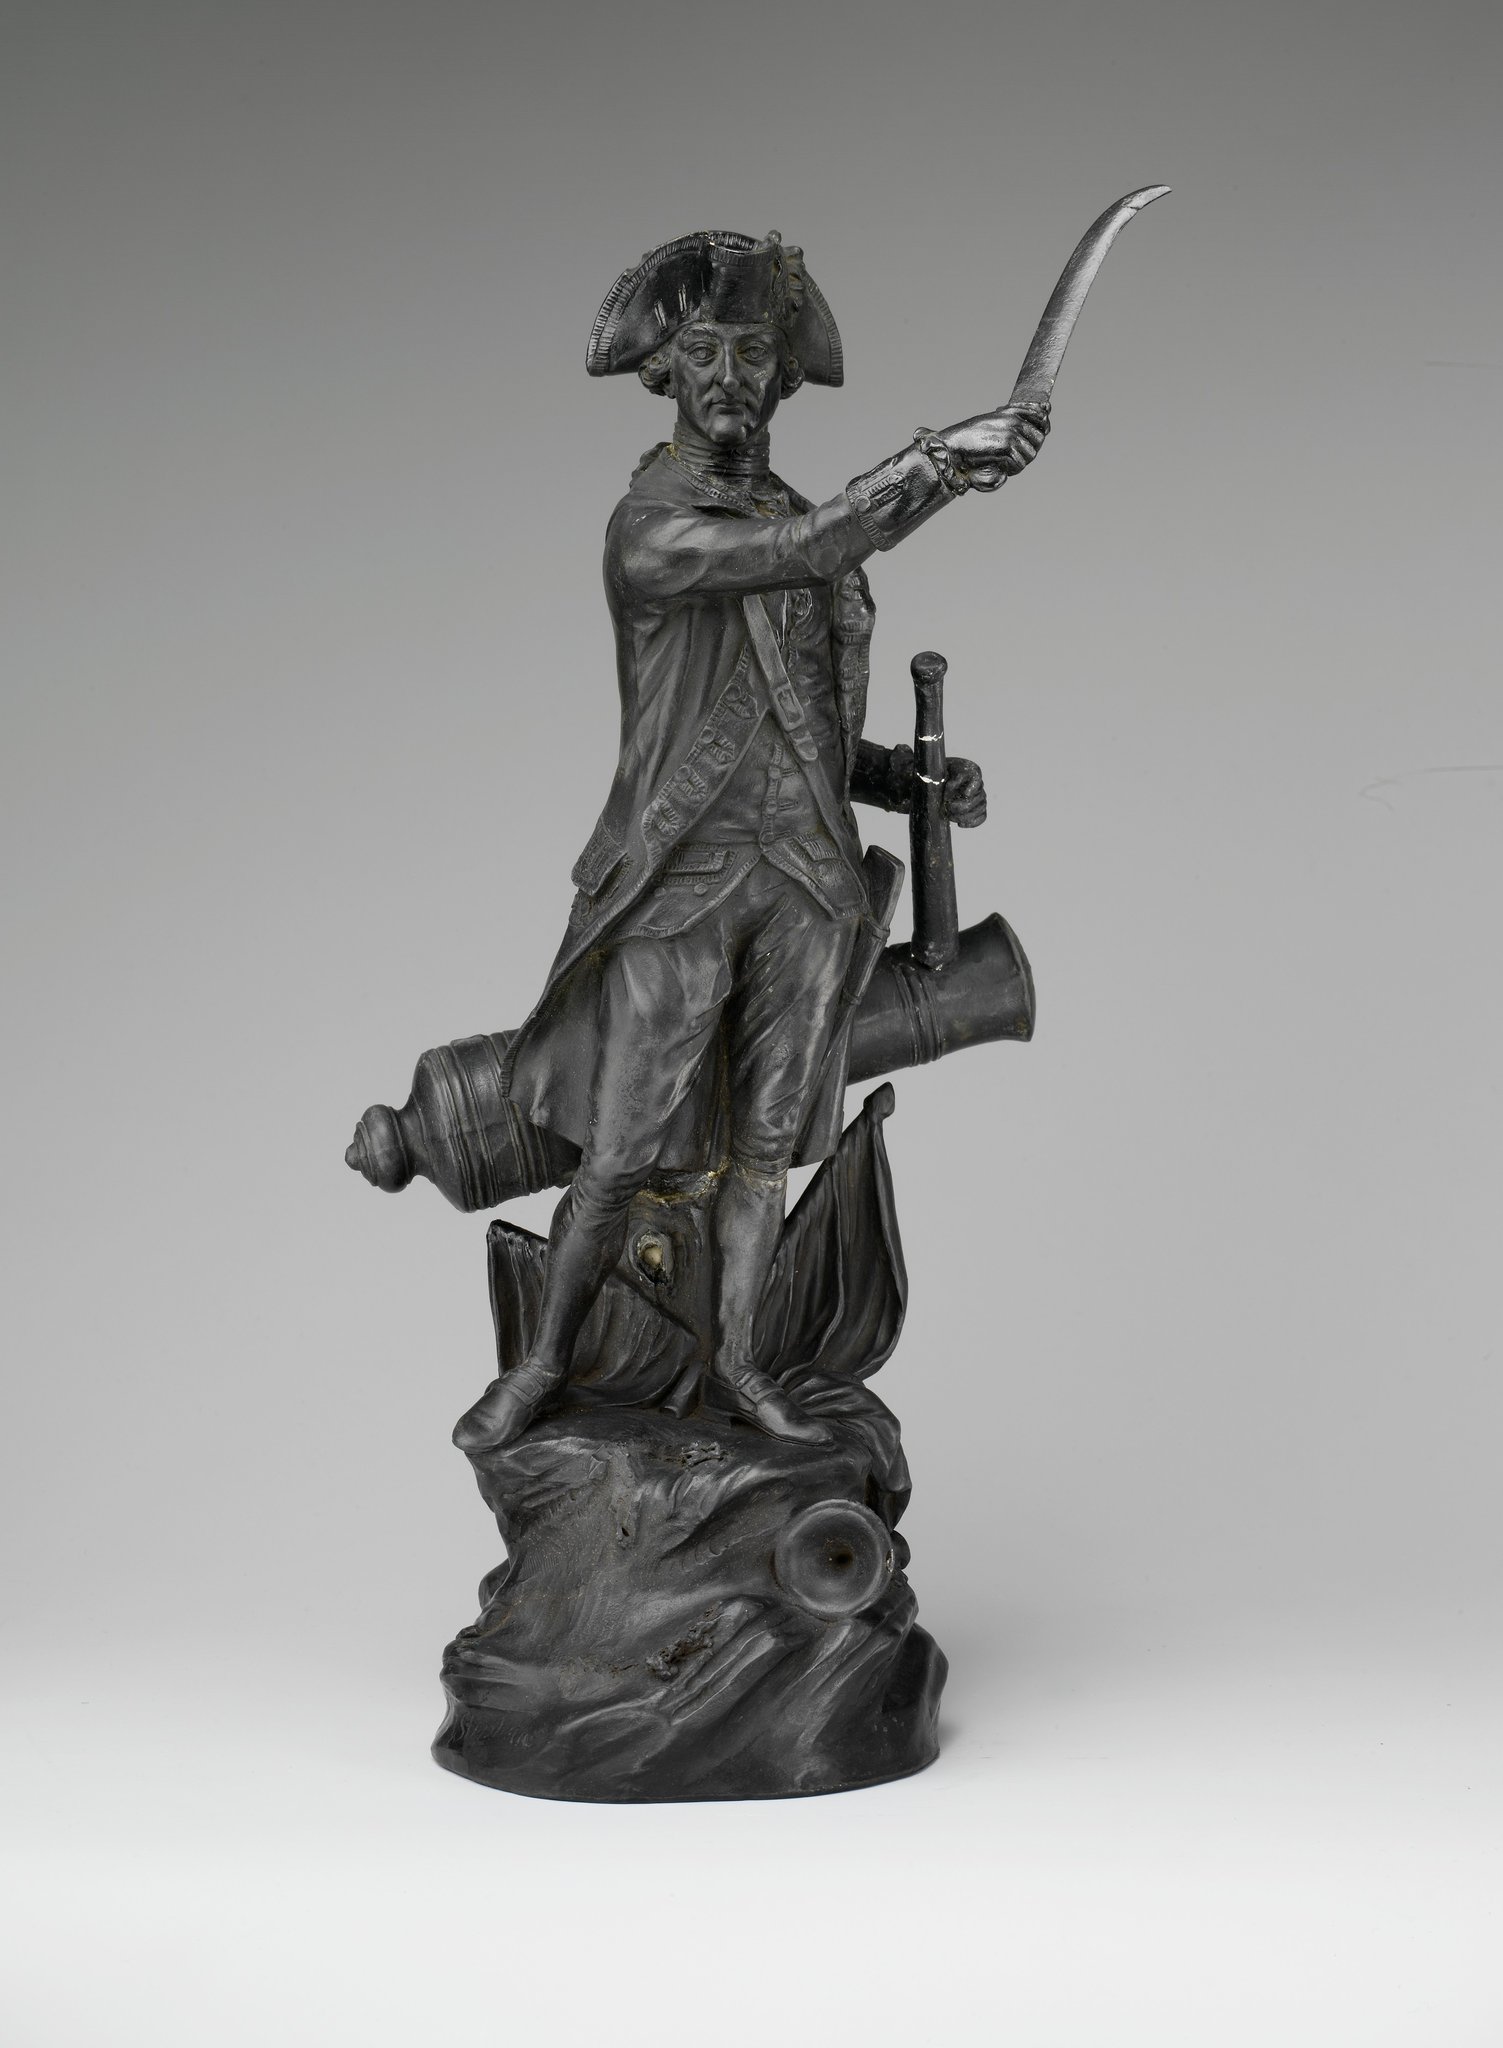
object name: figure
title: Figure of Admiral Samuel Hood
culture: british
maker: pierre stephan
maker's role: maker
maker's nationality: french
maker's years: 1765-1795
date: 1785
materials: stone, earthenware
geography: england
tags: cannons,swords,men,admirals